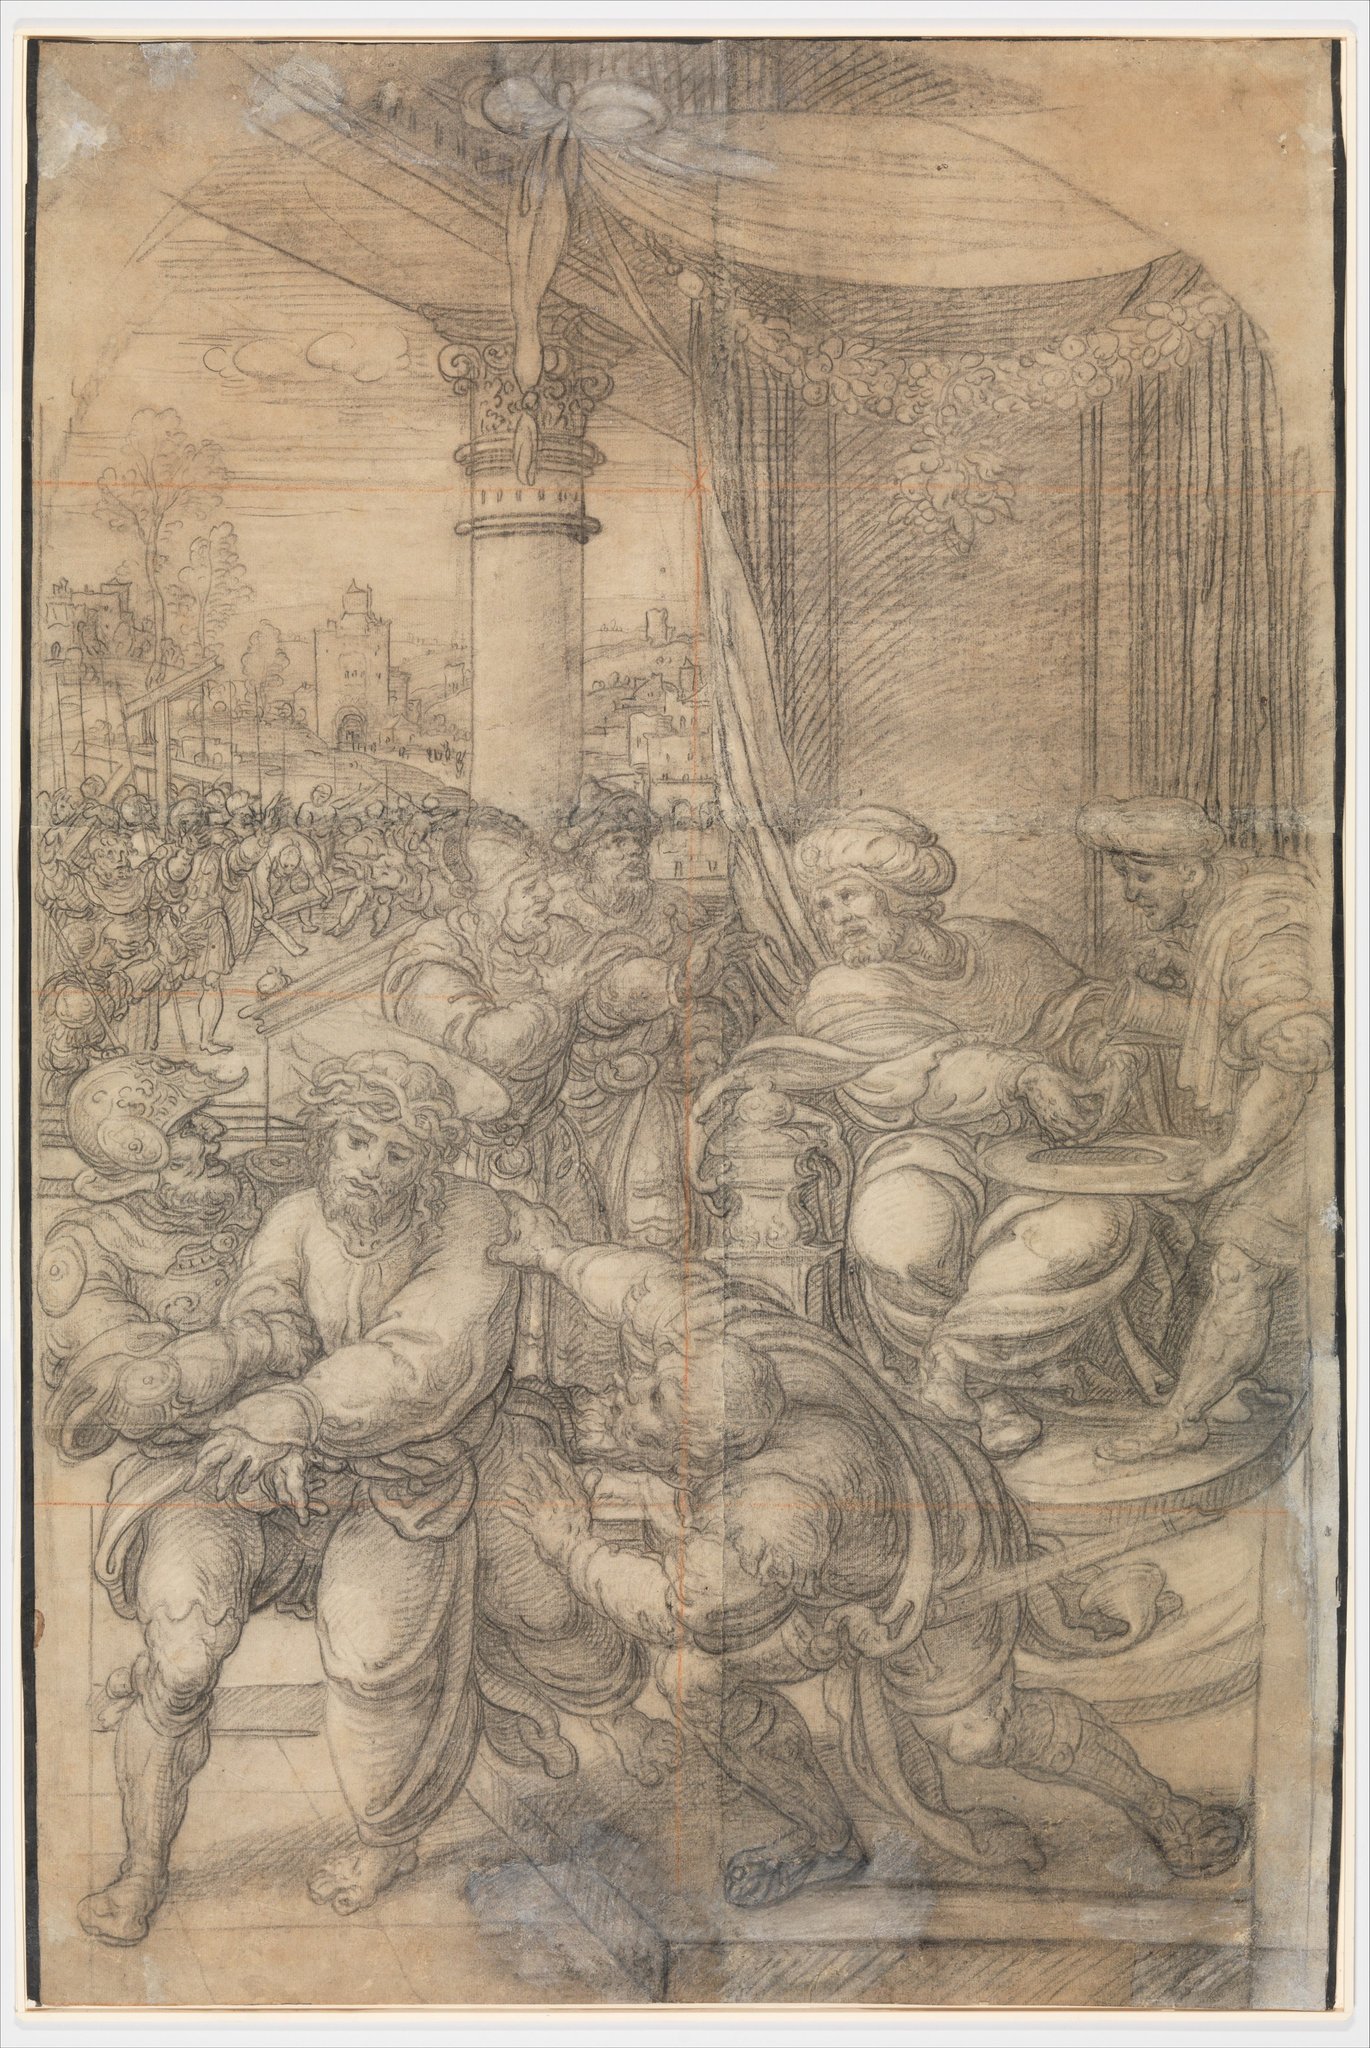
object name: drawing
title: Pilate Washing his Hands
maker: bernard van orley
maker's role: artist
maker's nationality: netherlandish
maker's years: 1492-1542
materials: chalk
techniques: drawing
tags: soldiers,men,christ,pilate